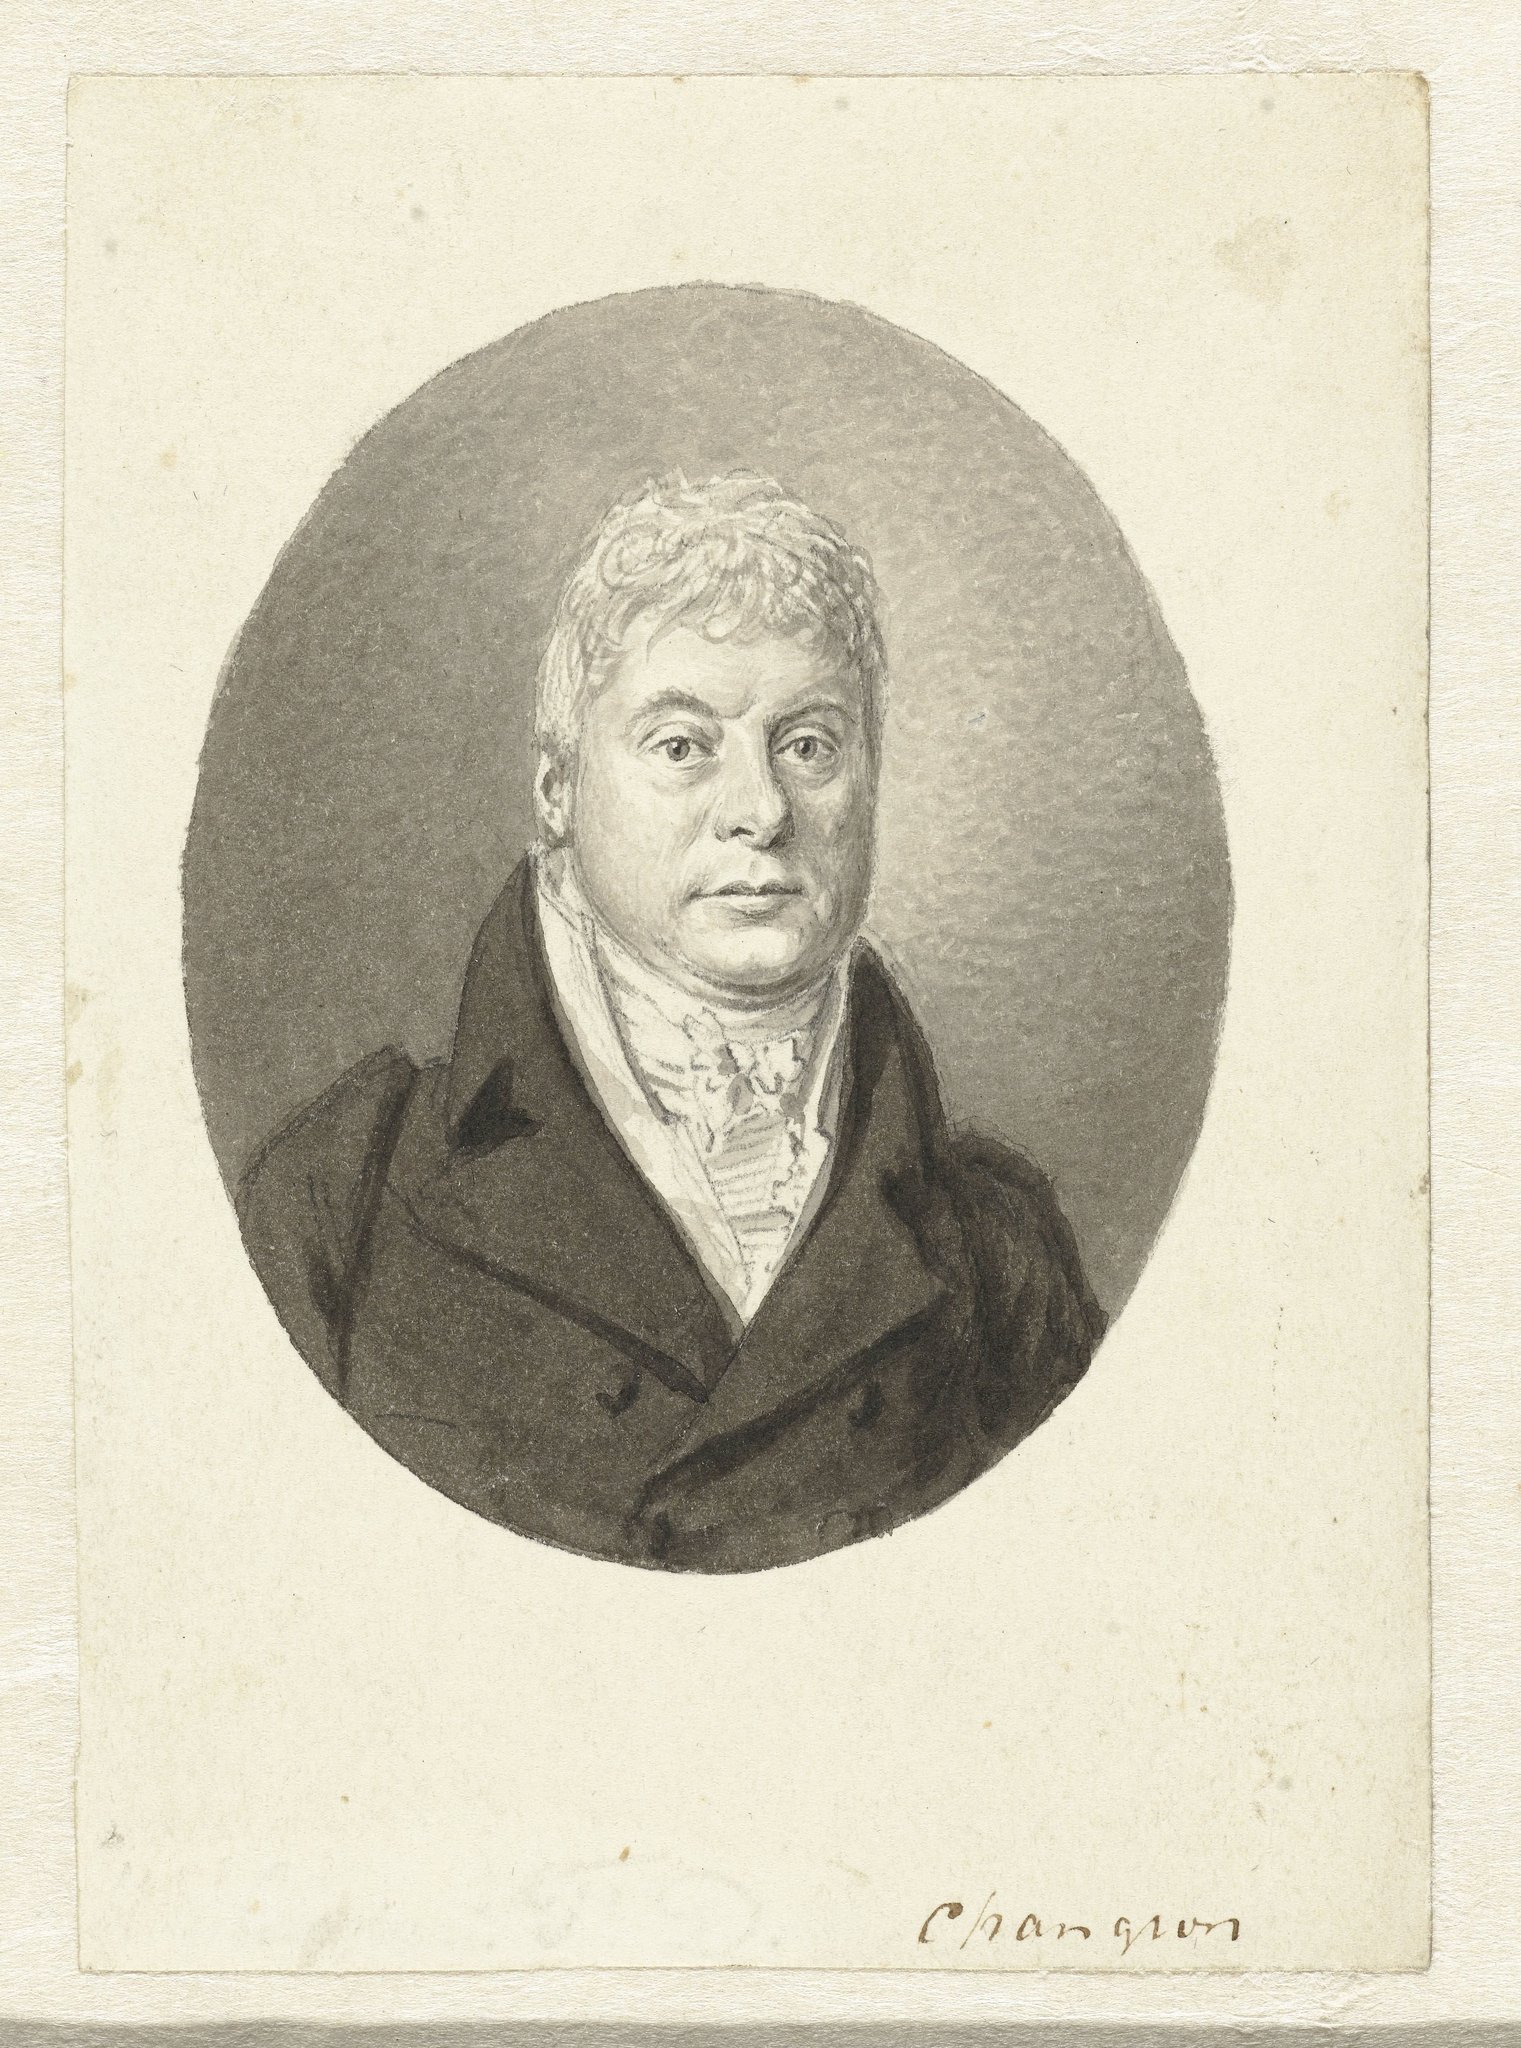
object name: drawing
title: Portret van F.D. Changuion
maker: hendrik willem caspari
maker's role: draughtsman, print maker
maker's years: 1770-1829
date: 1780-1829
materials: ink, paper, pencil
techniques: brush, pen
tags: historical persons